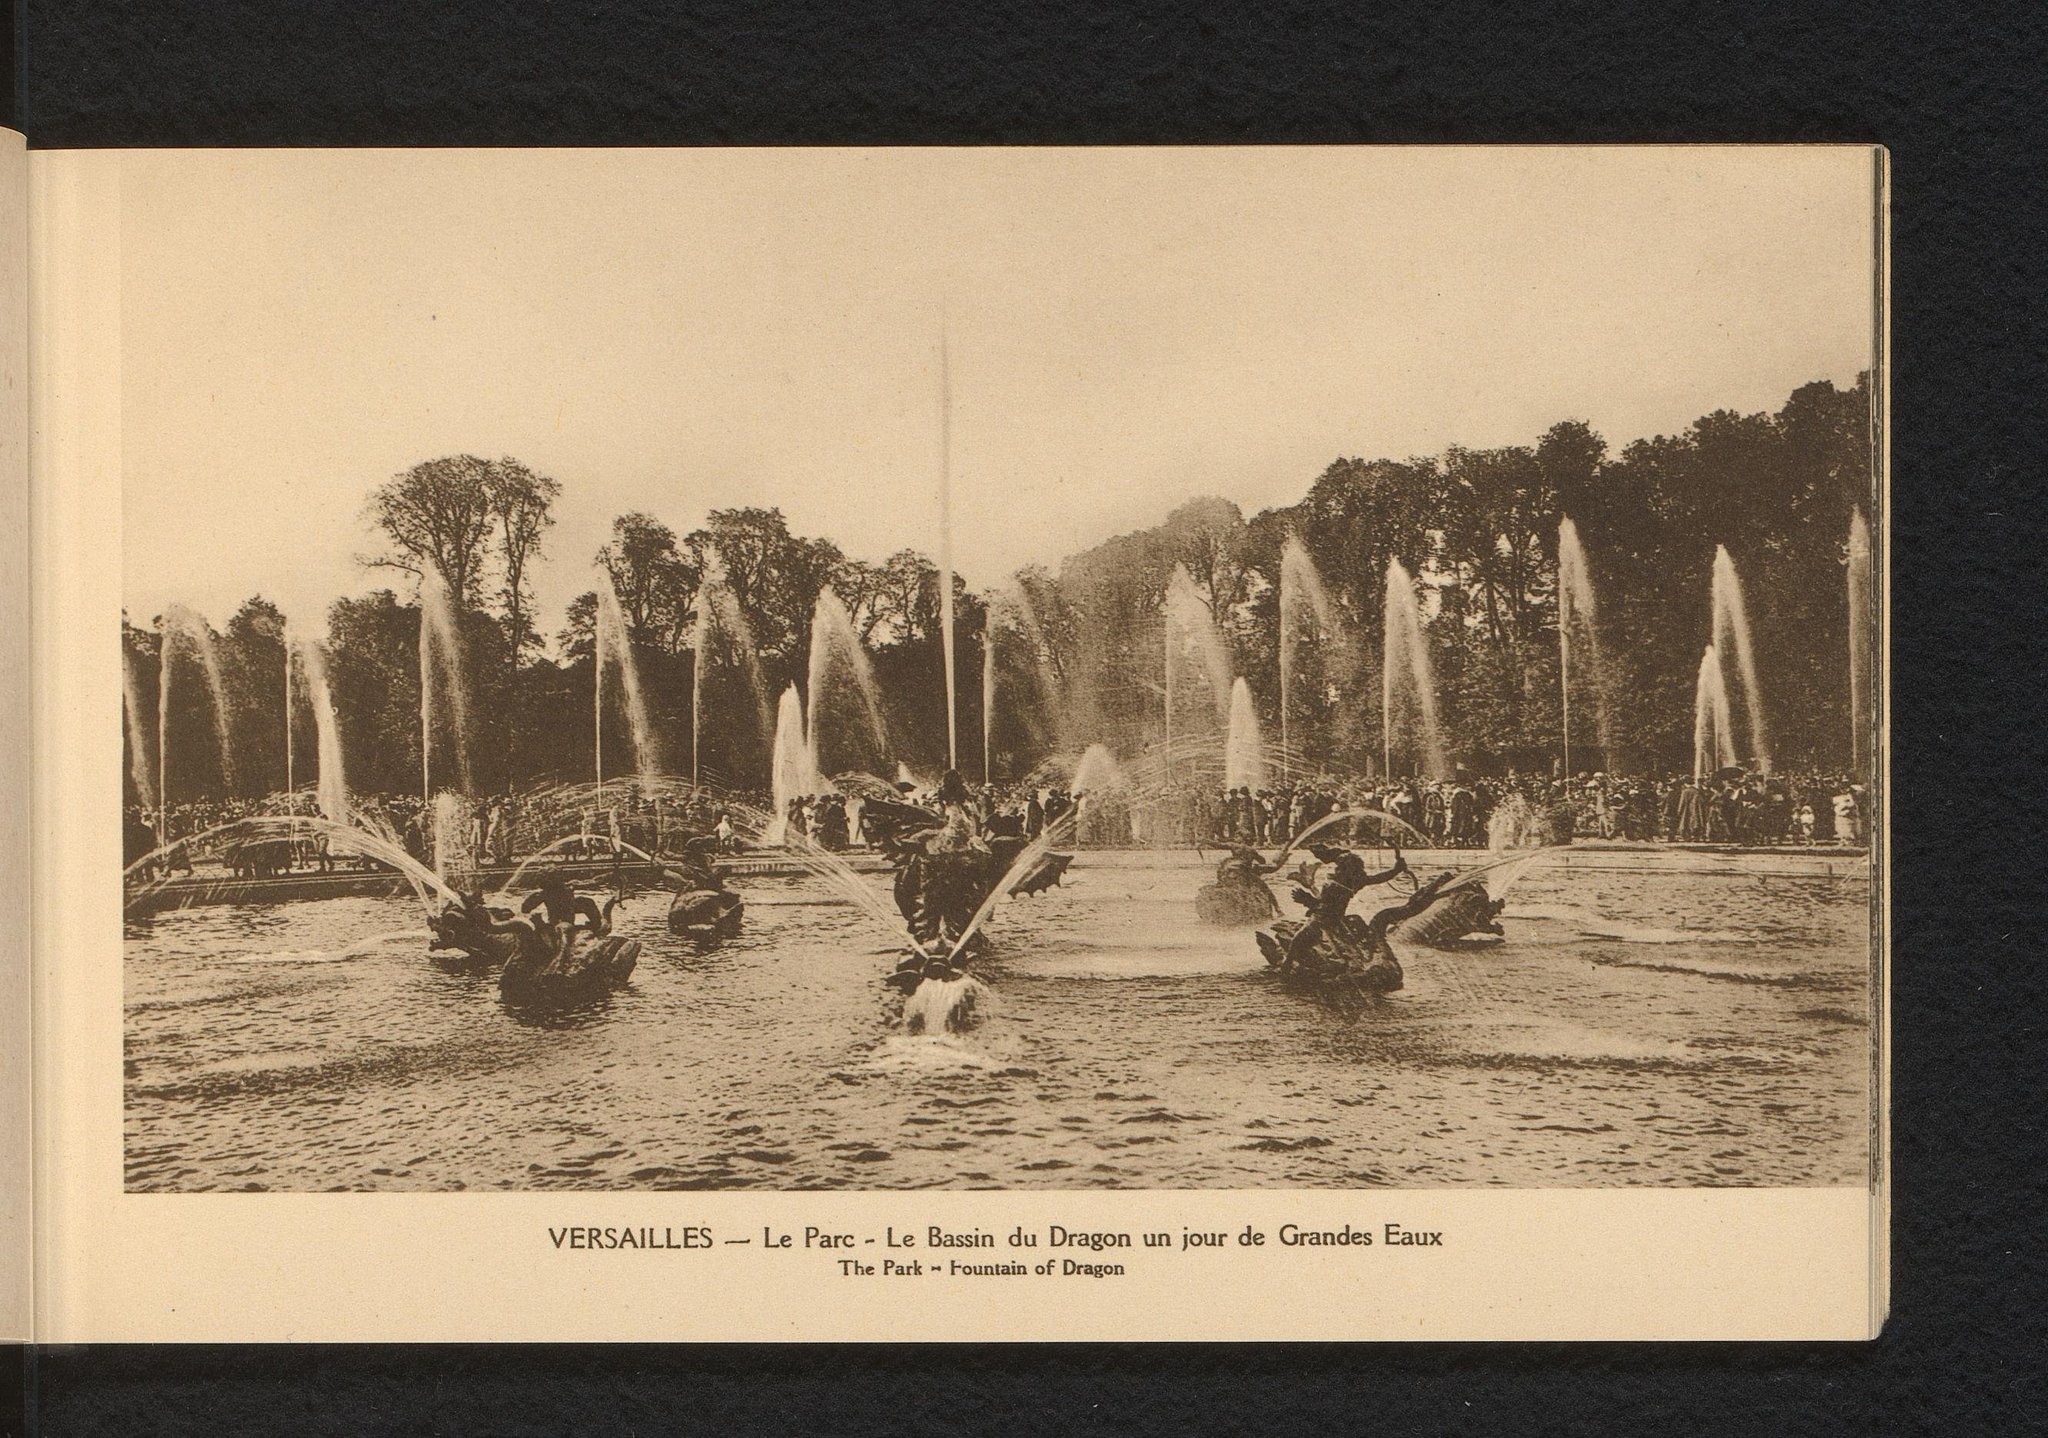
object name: photomechanical print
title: Versailles. Le Parc. Le Bassin du Dragon un jour de Grandes Eaux / The Park. Tountain of Dragon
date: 1919-1930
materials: cardboard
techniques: photograph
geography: versailles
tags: garden fountain, french or architectonic garden; formal garden